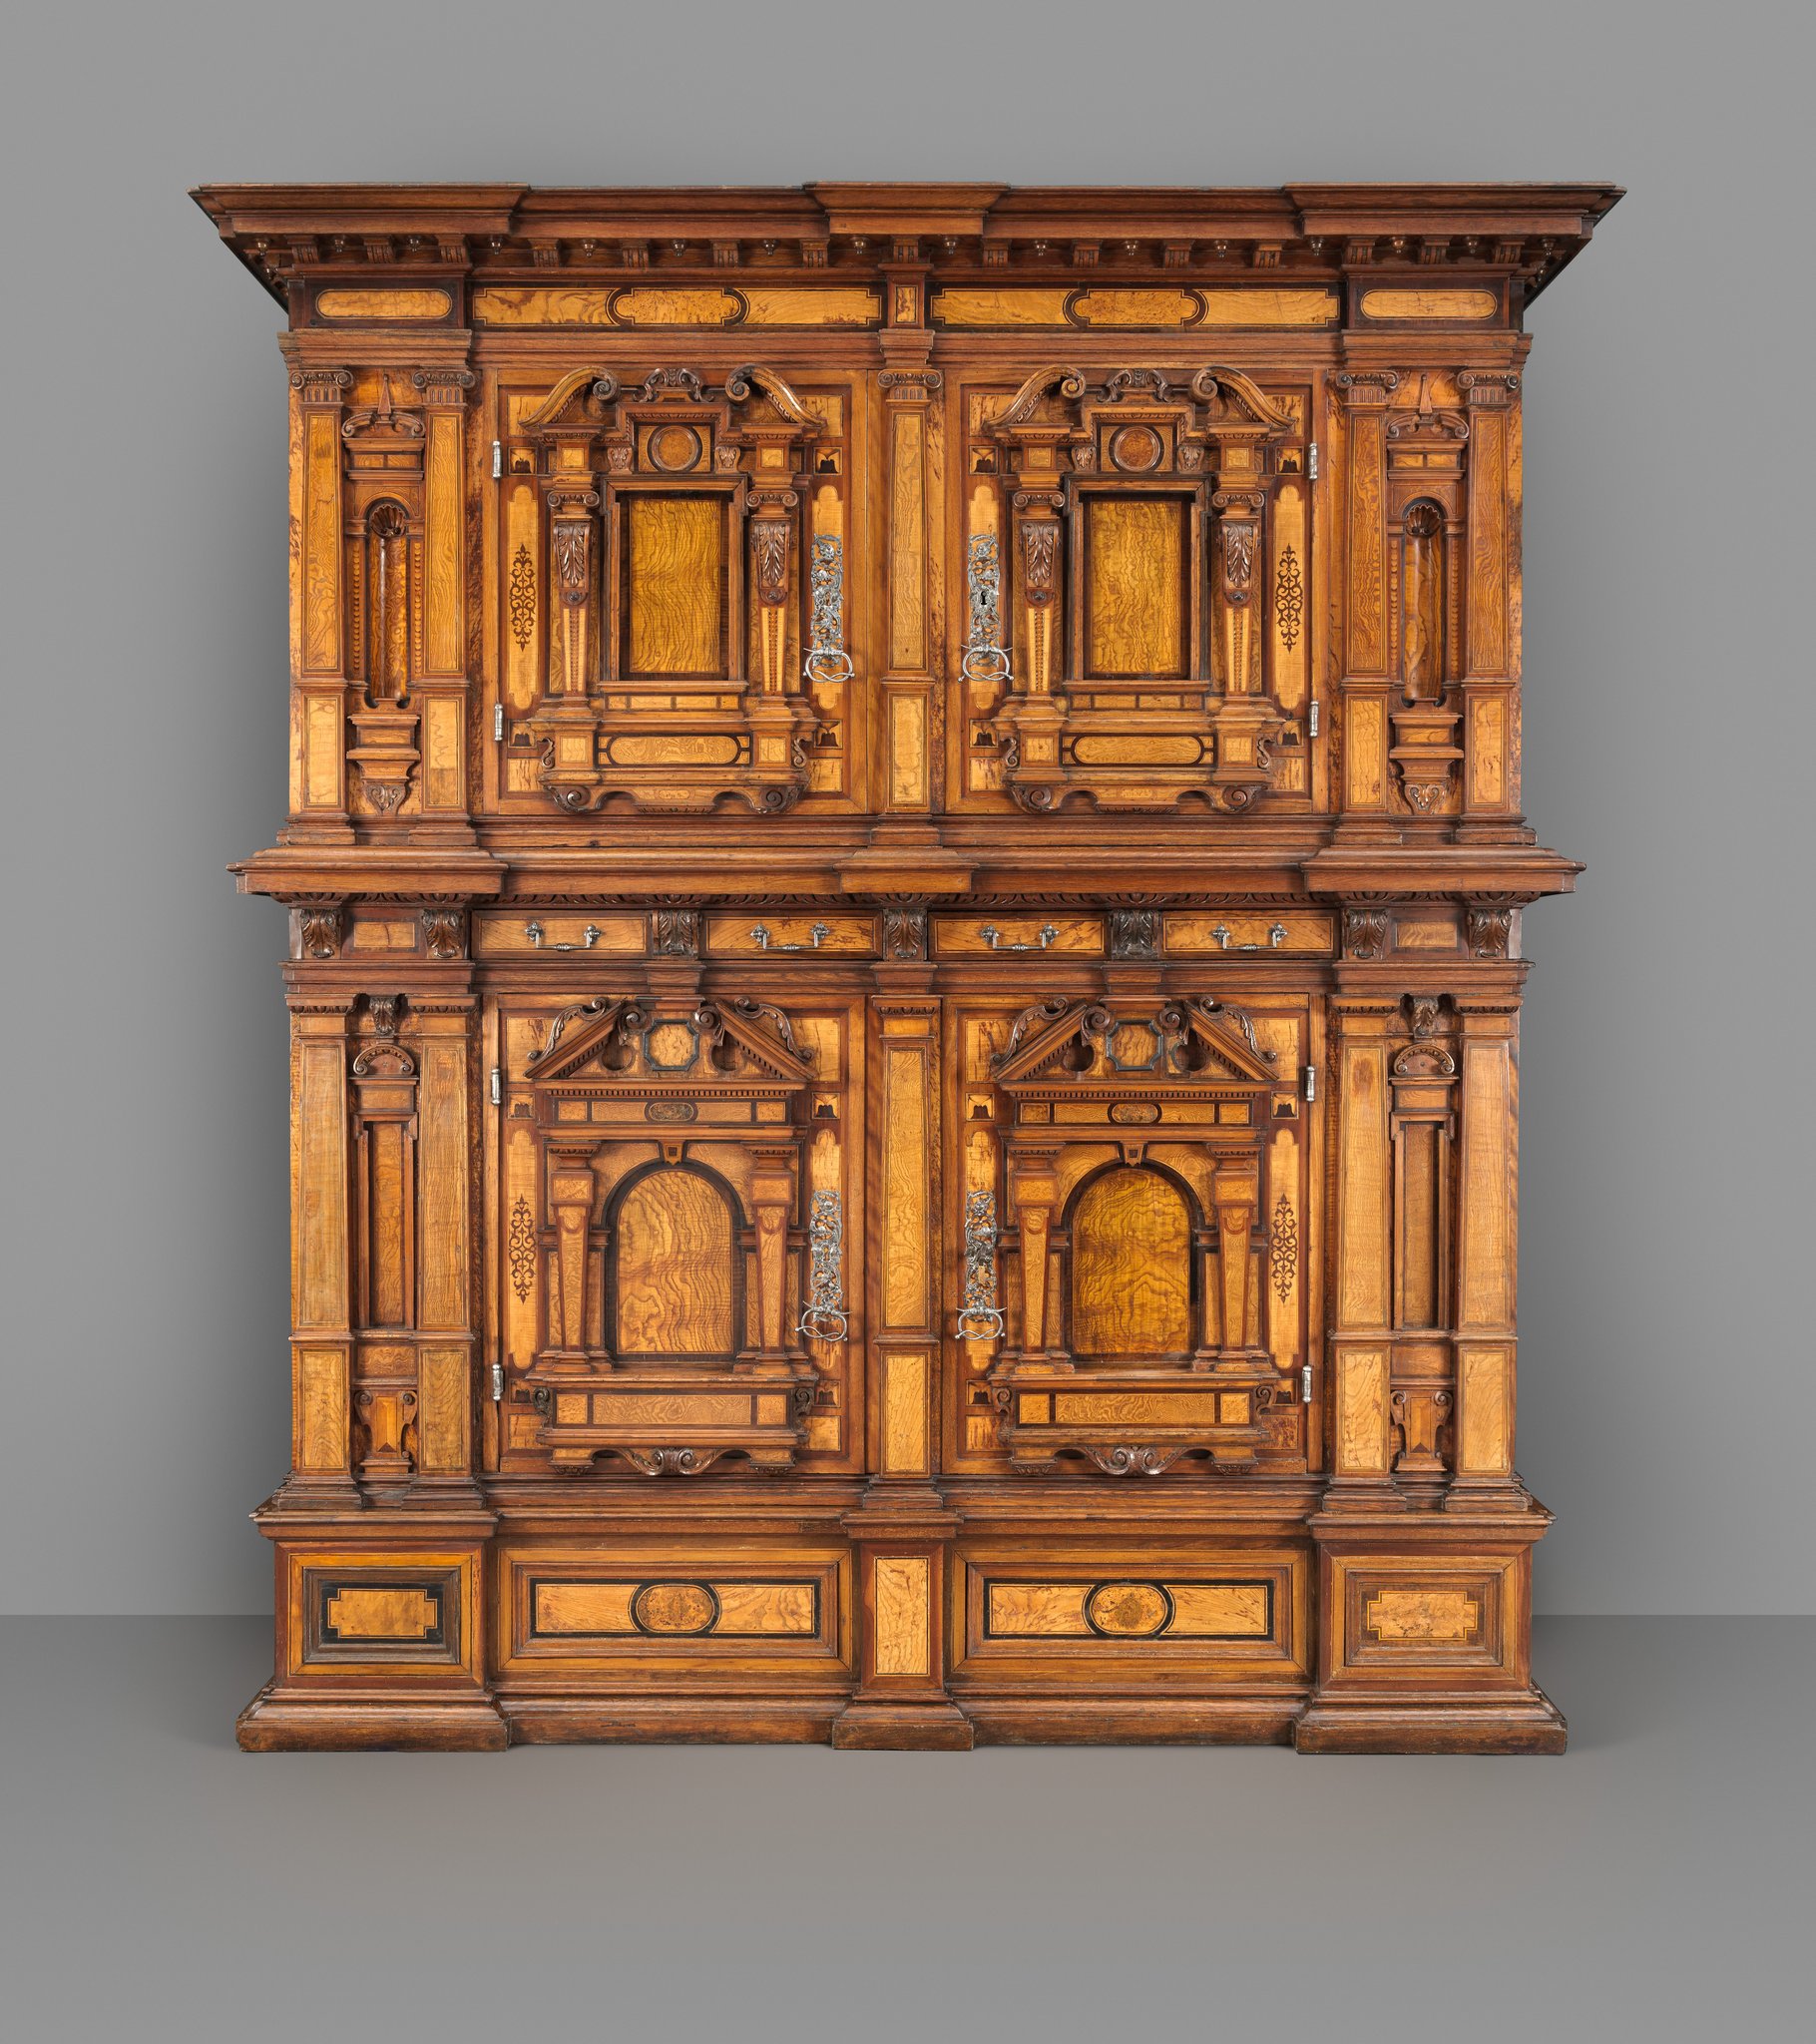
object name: cabinet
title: Cabinet (Fassadenschrank)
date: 1601-1633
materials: wood, iron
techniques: stain, veneering